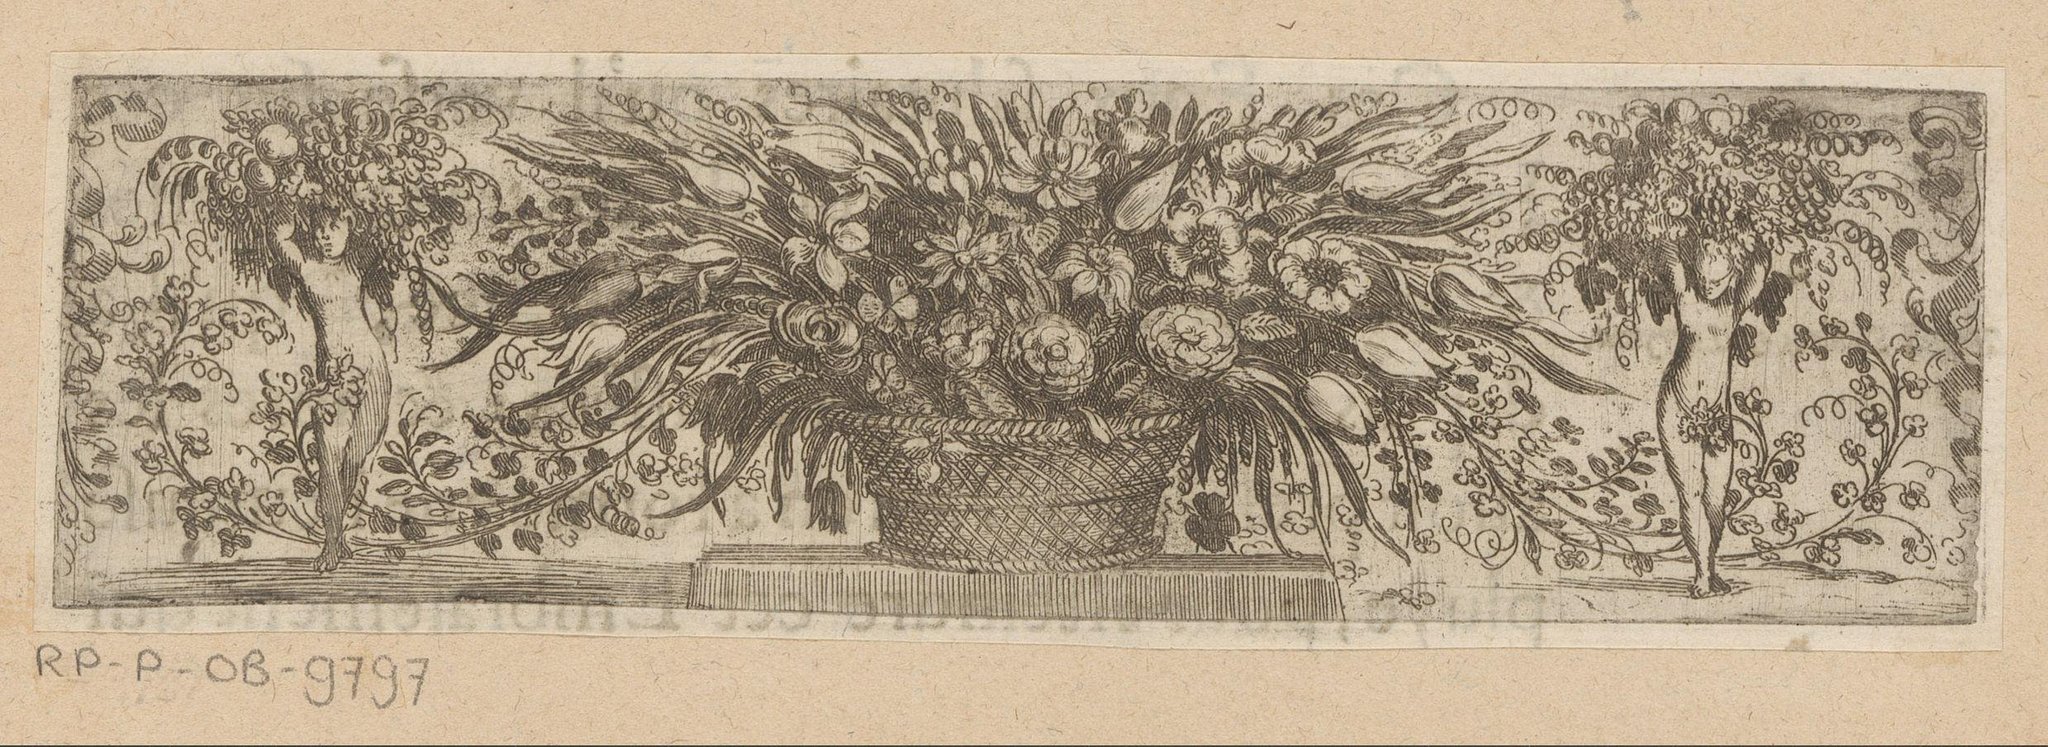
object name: print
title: Fries met bloemenmand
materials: paper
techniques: etching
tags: cut flowers; nosegay, bunch of flowers, ornaments ~ art, container made of plant material other than wood: basket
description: Prent uit: Bardin, Philippe. Le Triomphe De Son Altesse Charles IIII (...). Nancy: Poirel, Dominique, Charlot Anthoine en Charlot Claude, 1664.